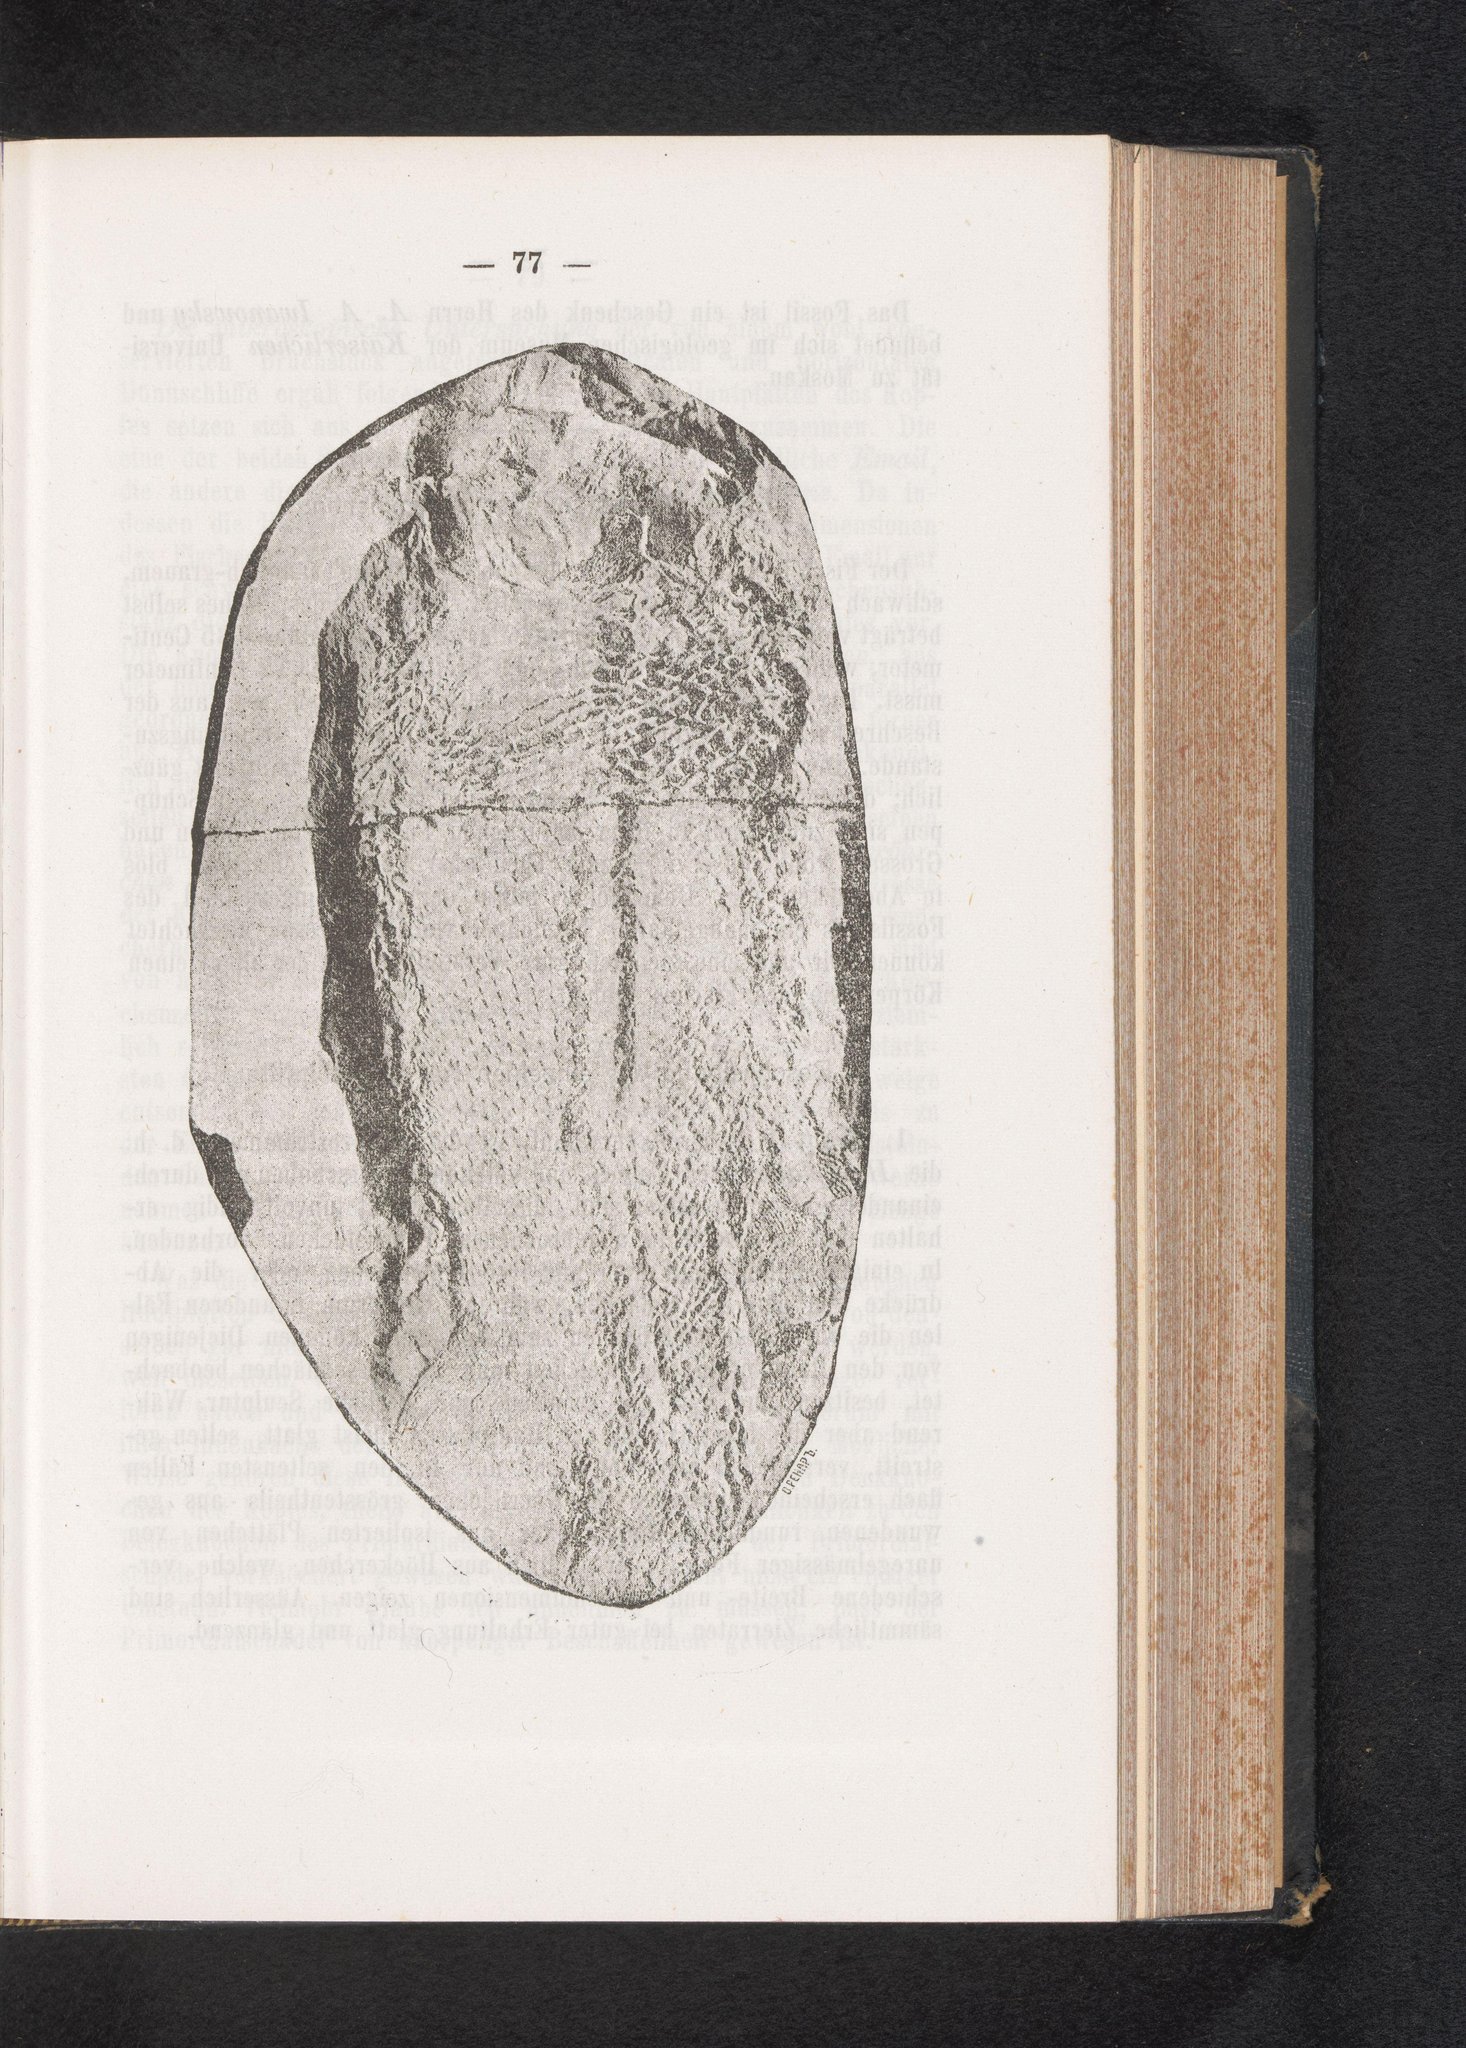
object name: photomechanical print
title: Fossiel van een vis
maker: Anonymous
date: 1888-1893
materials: paper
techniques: autotype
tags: fossil animals